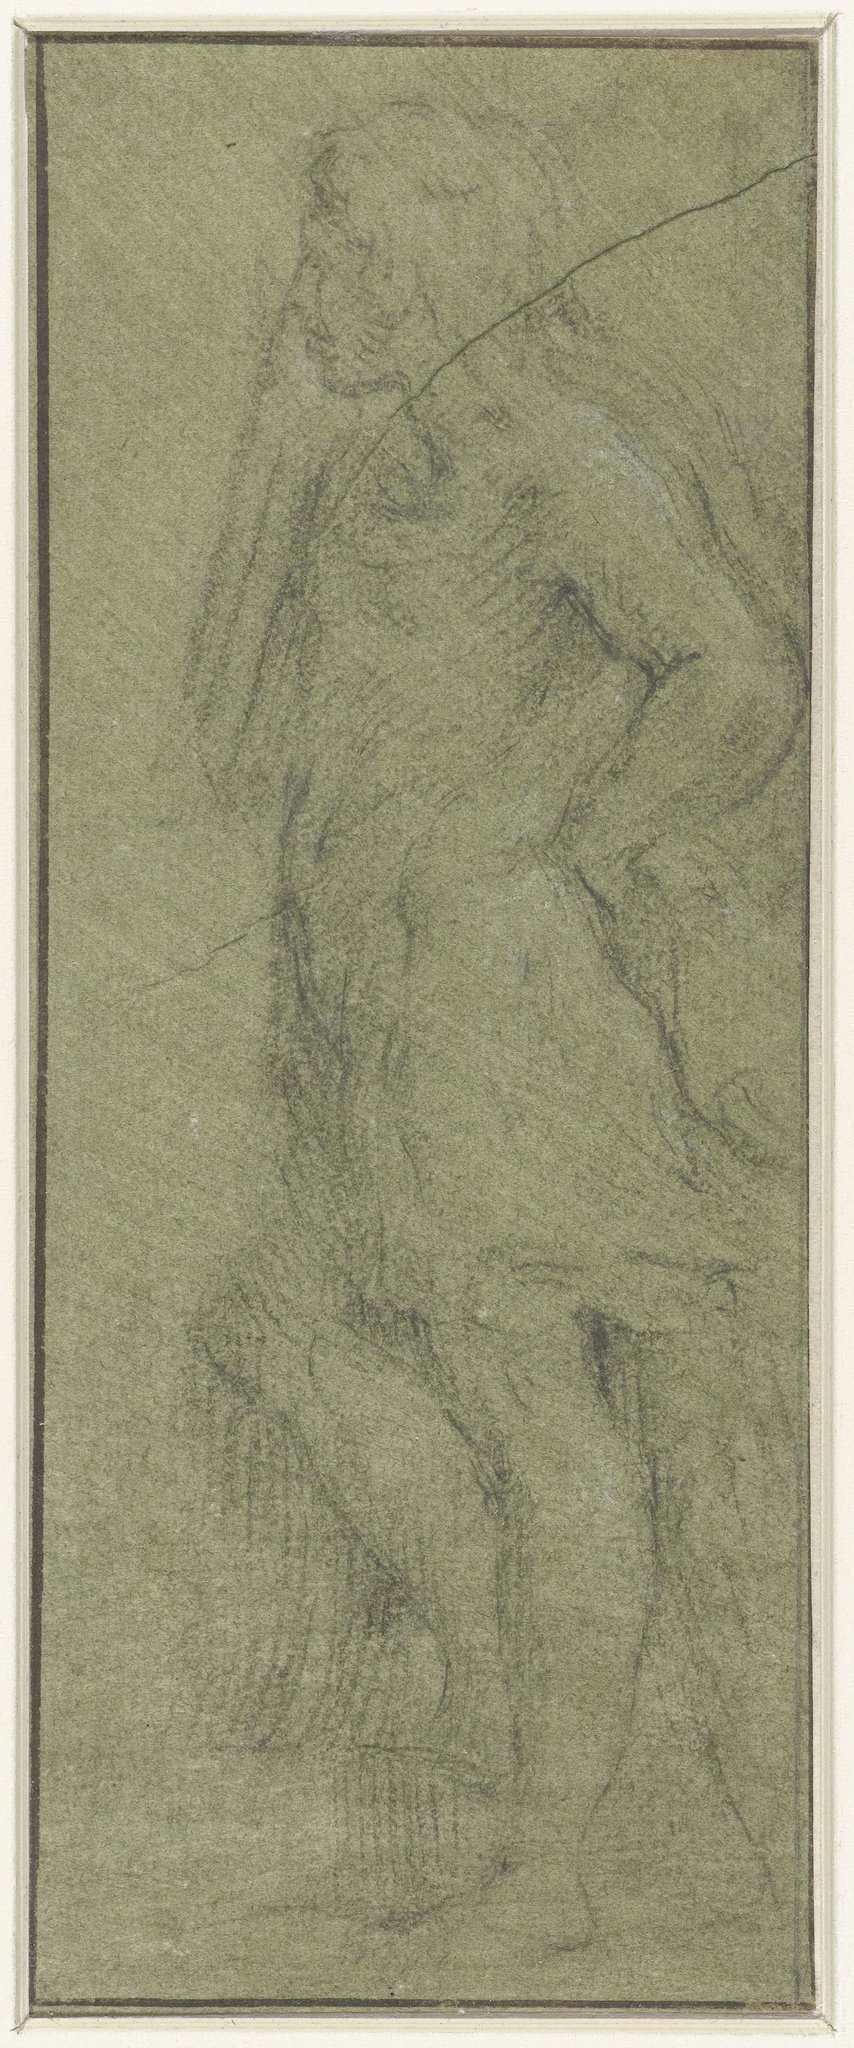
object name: drawing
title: Staande figuur, in profiel naar links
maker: schiavone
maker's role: draughtsman, painter, print maker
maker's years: 1500-1563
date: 1510-1563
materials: chalk, paper